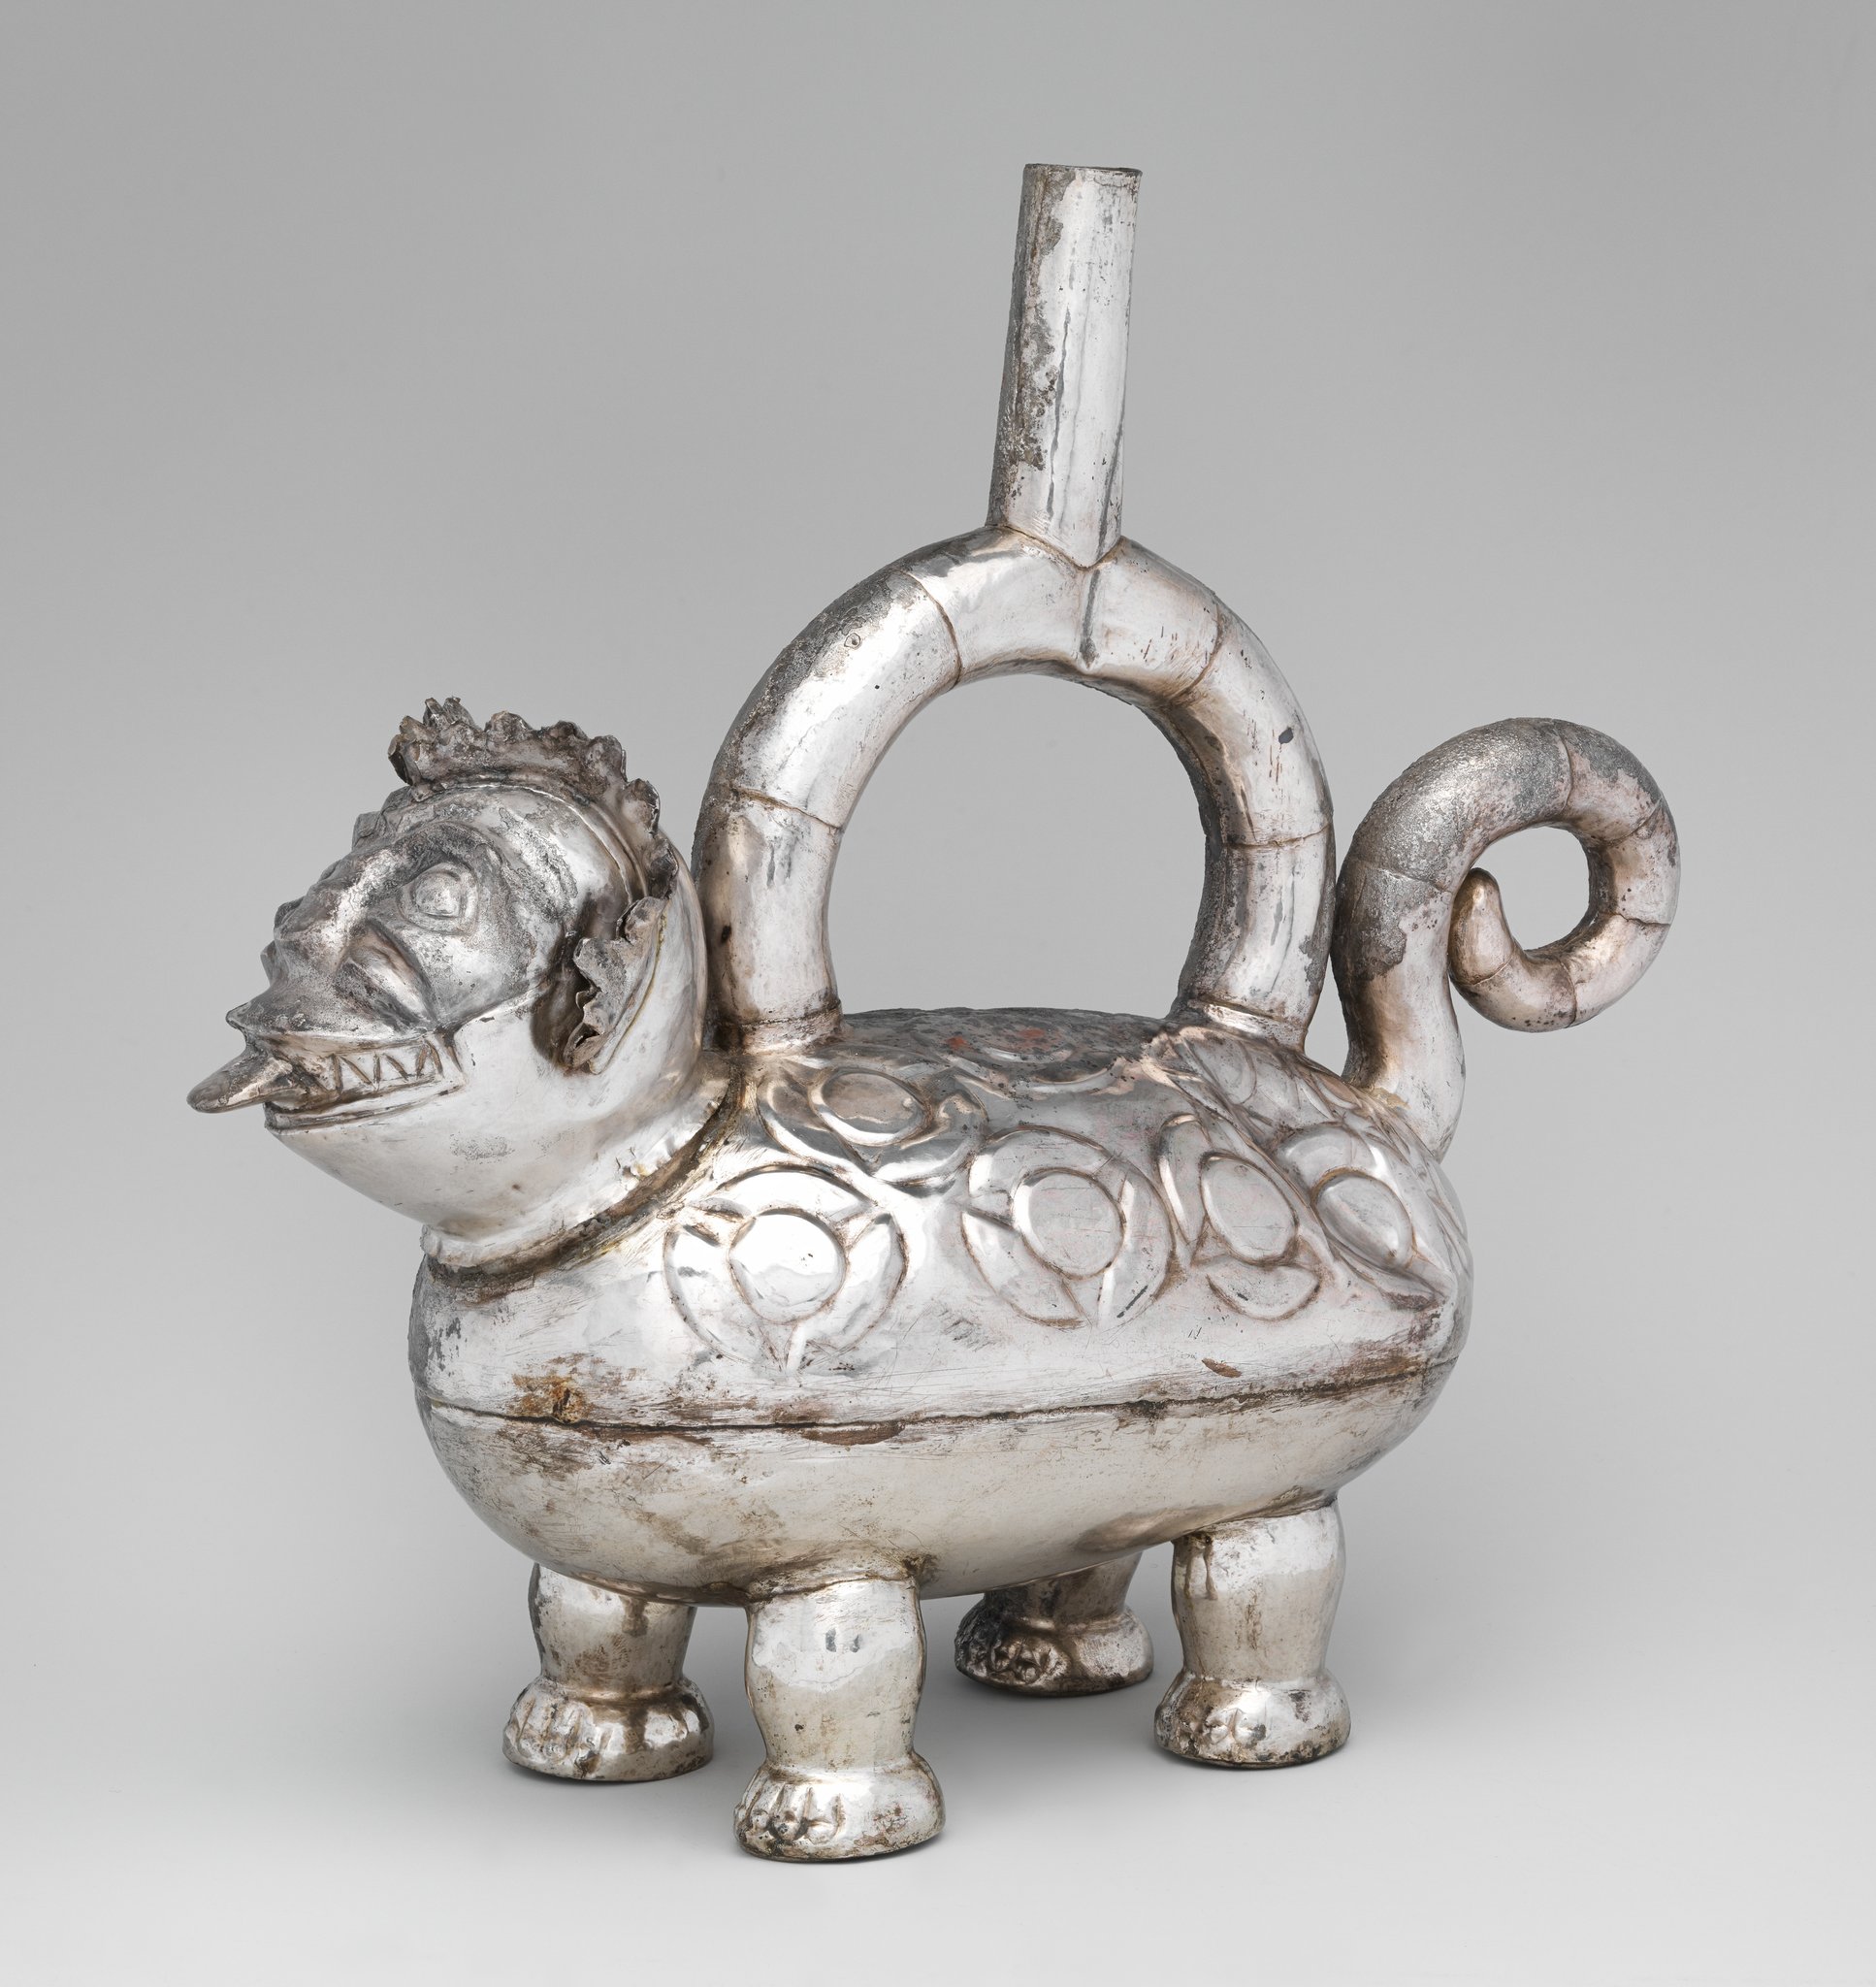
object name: bottle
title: Stirrup-spout bottle with feline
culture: chimú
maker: chimú artist(s)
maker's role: artist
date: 1350-1470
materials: silver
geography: peru